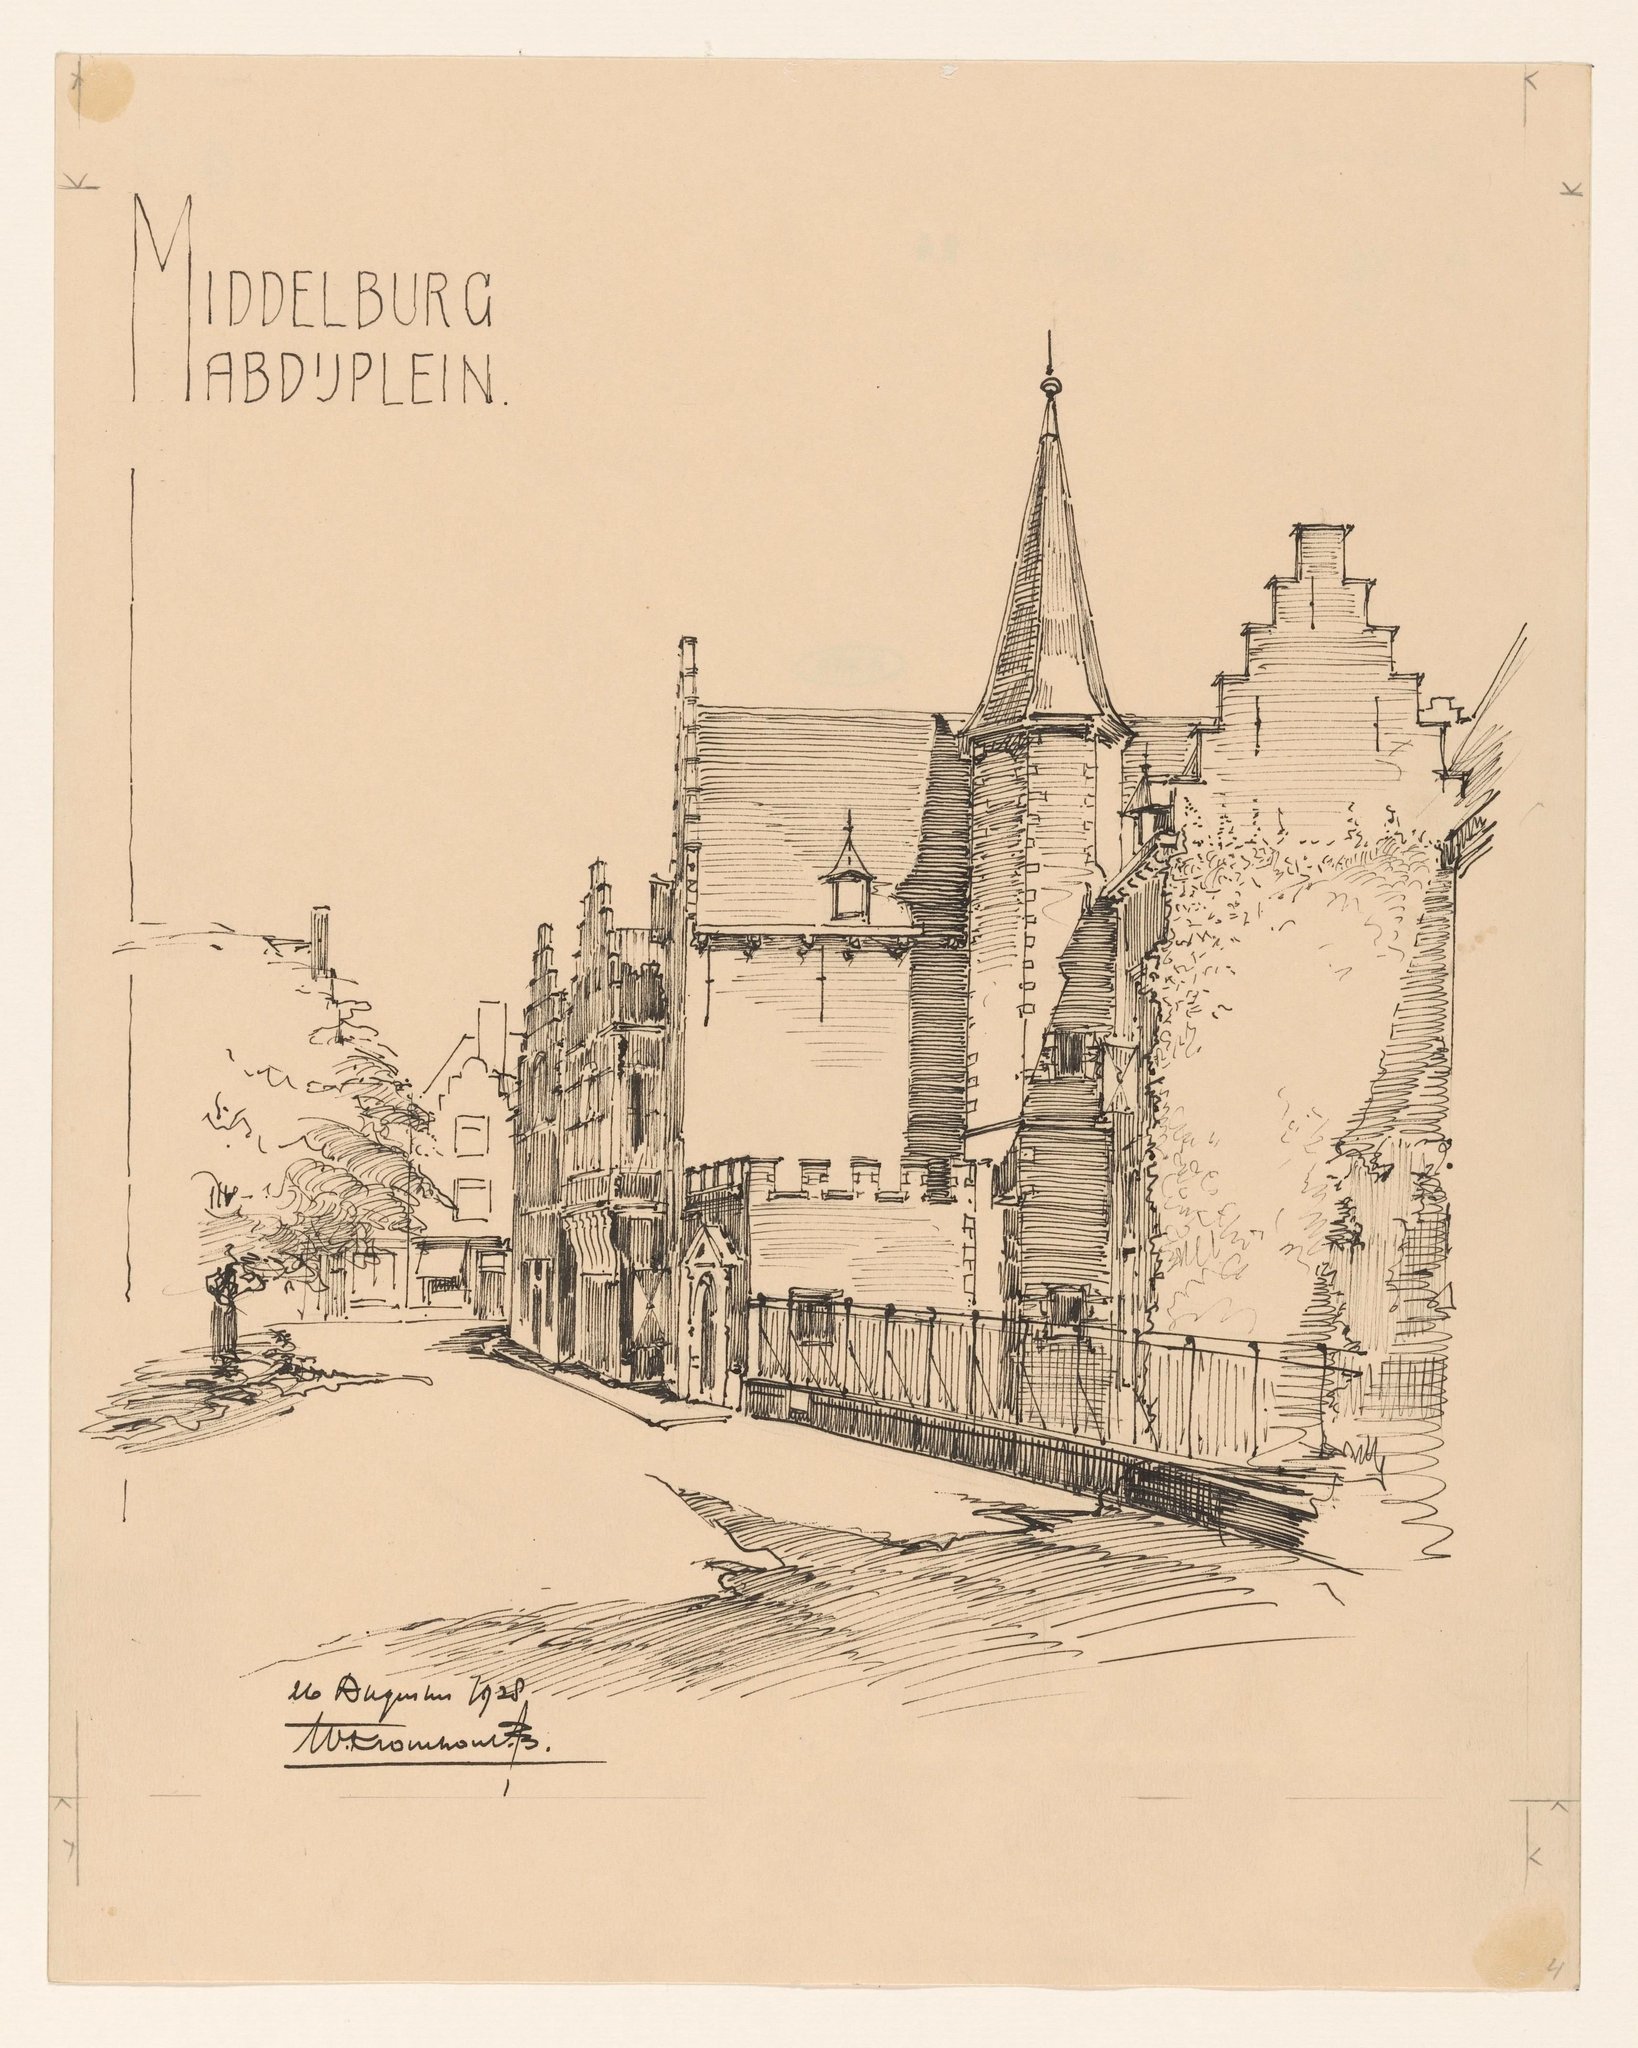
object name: drawing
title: Het Abdijplein te Middelburg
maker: willem kromhout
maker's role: draughtsman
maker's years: 1864-1940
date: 1928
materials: ink, paper, pencil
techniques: pen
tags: square, place, circus, etc., middelburg